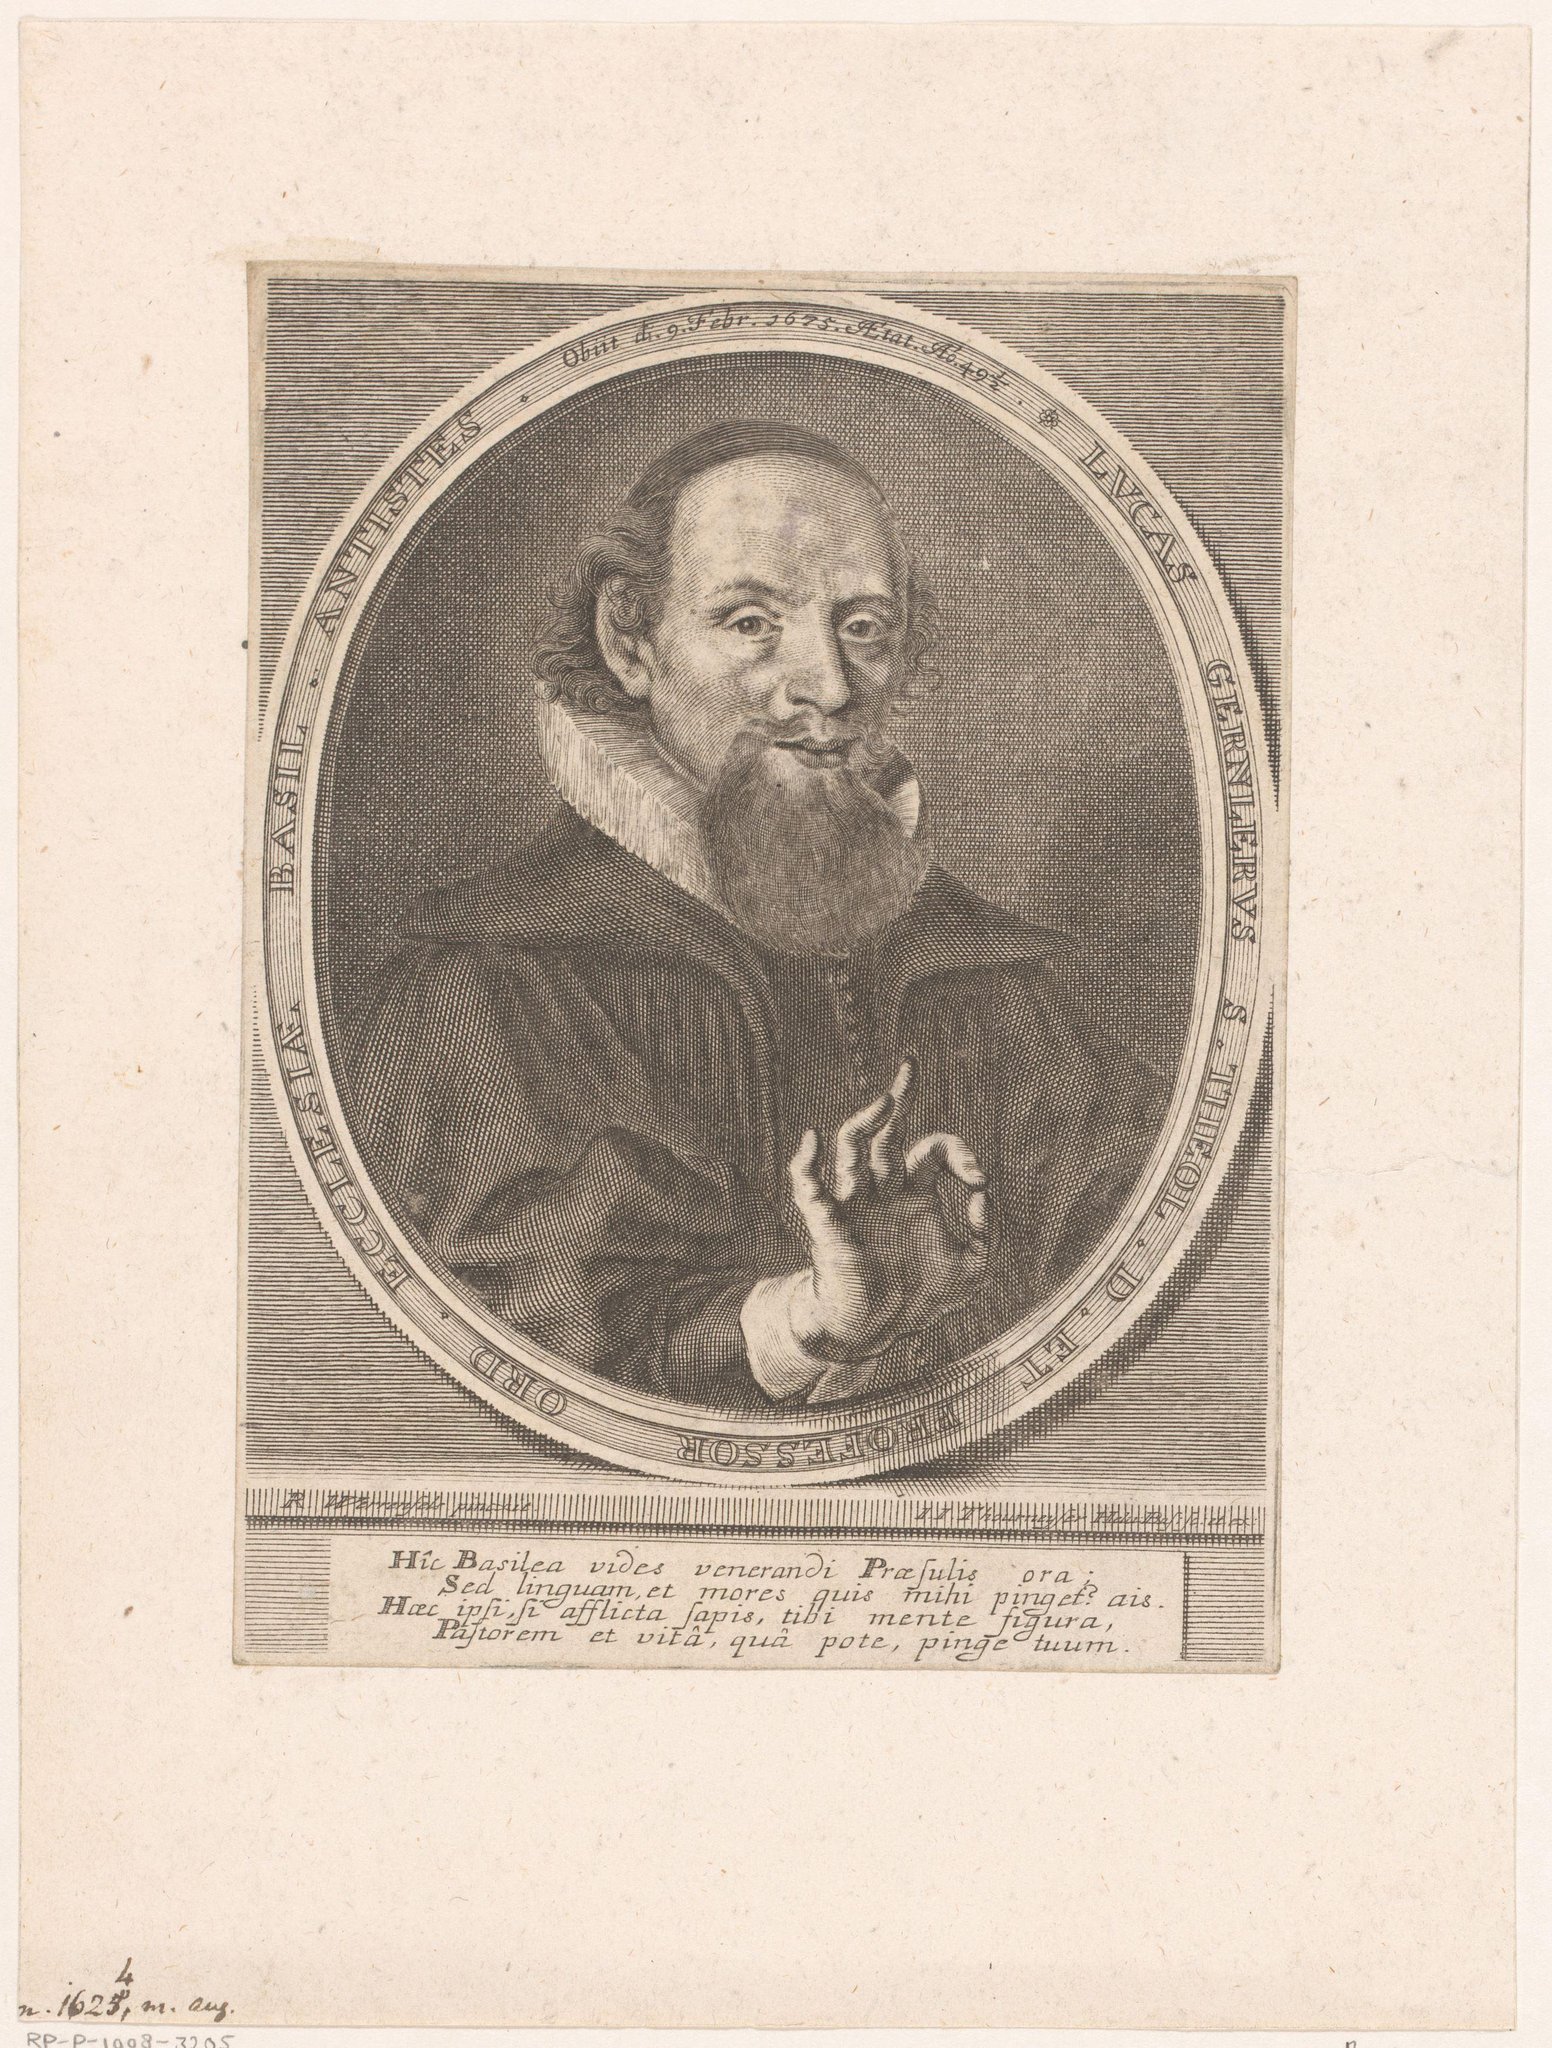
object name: print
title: Portret van Lukas Gernler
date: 1675-1711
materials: paper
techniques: engraving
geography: basel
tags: historical persons